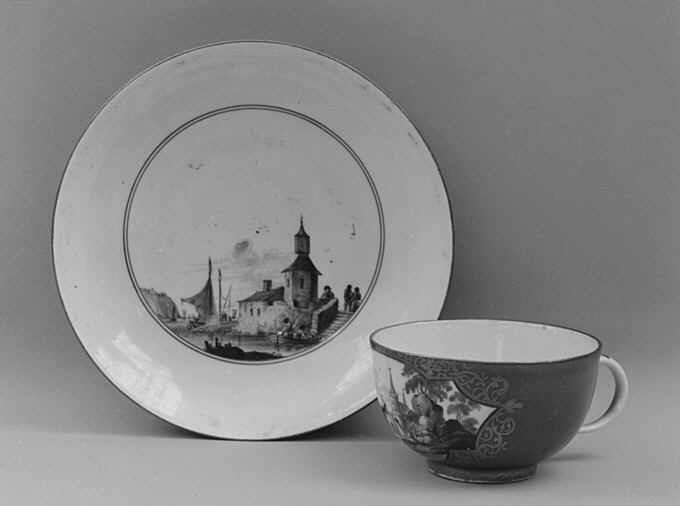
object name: saucer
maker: meissen manufactory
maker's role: manufactory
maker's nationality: german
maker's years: 1710-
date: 1740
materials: hard paste porcelain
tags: human figures,buildings,boats